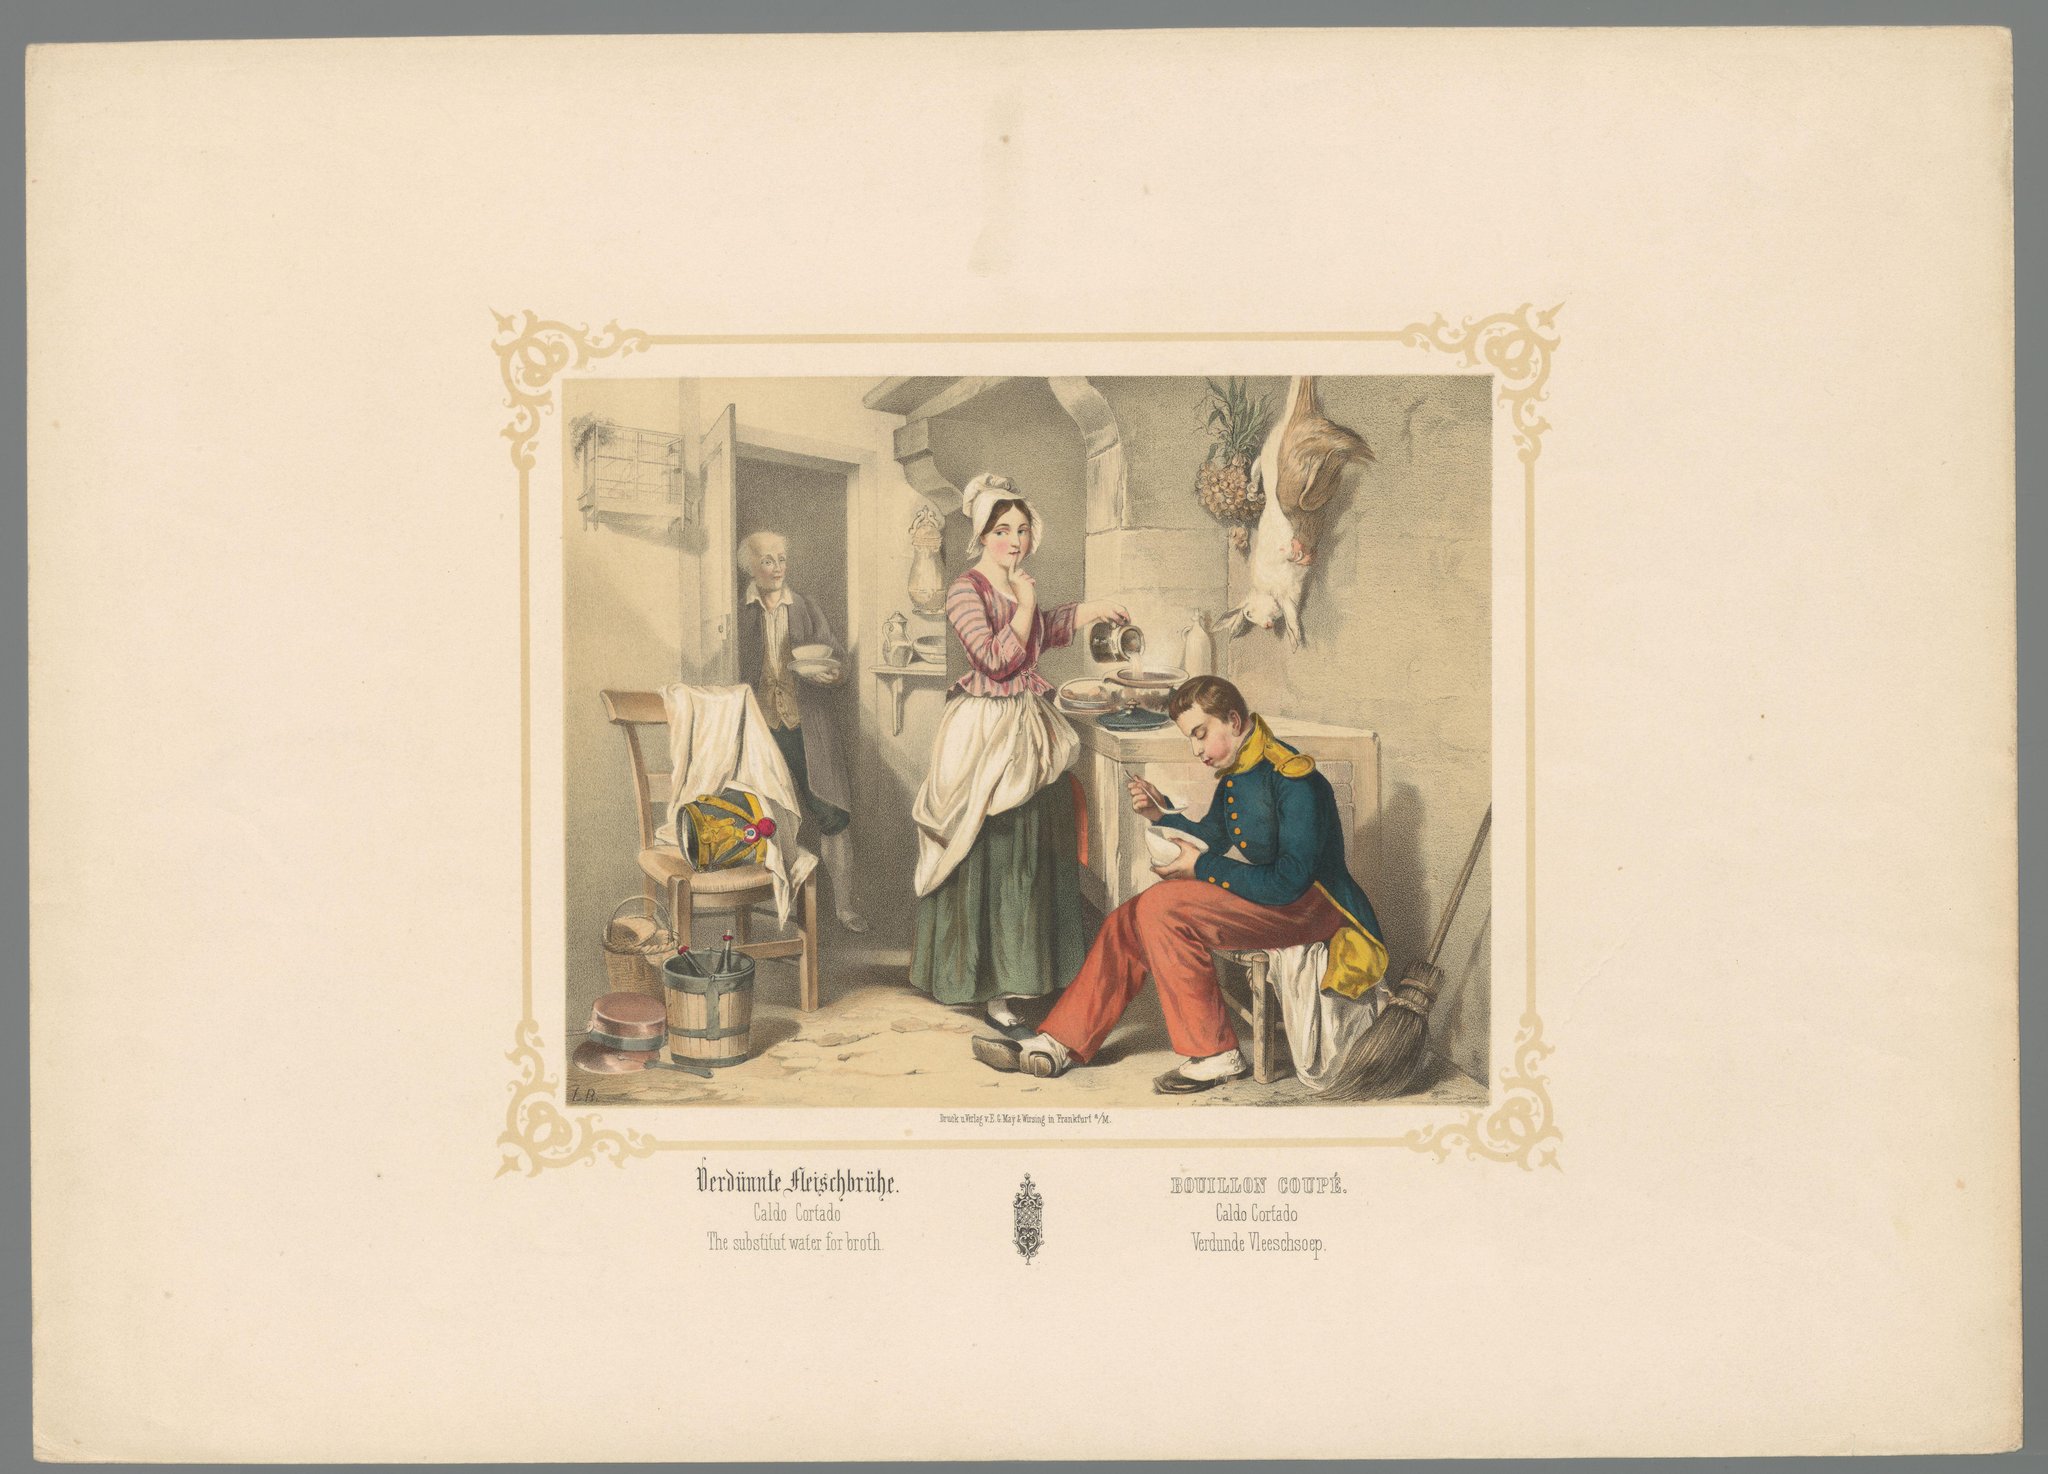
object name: print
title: Vrouw aan het koken en een jongeman eet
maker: monogrammist lb (duitsland 19e eeuw)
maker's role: draughtsman, print maker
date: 1850-1863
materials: paper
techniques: hand coloring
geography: frankfurt am main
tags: kitchen, cooking food, eating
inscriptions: collector's mark: Lugt 2228